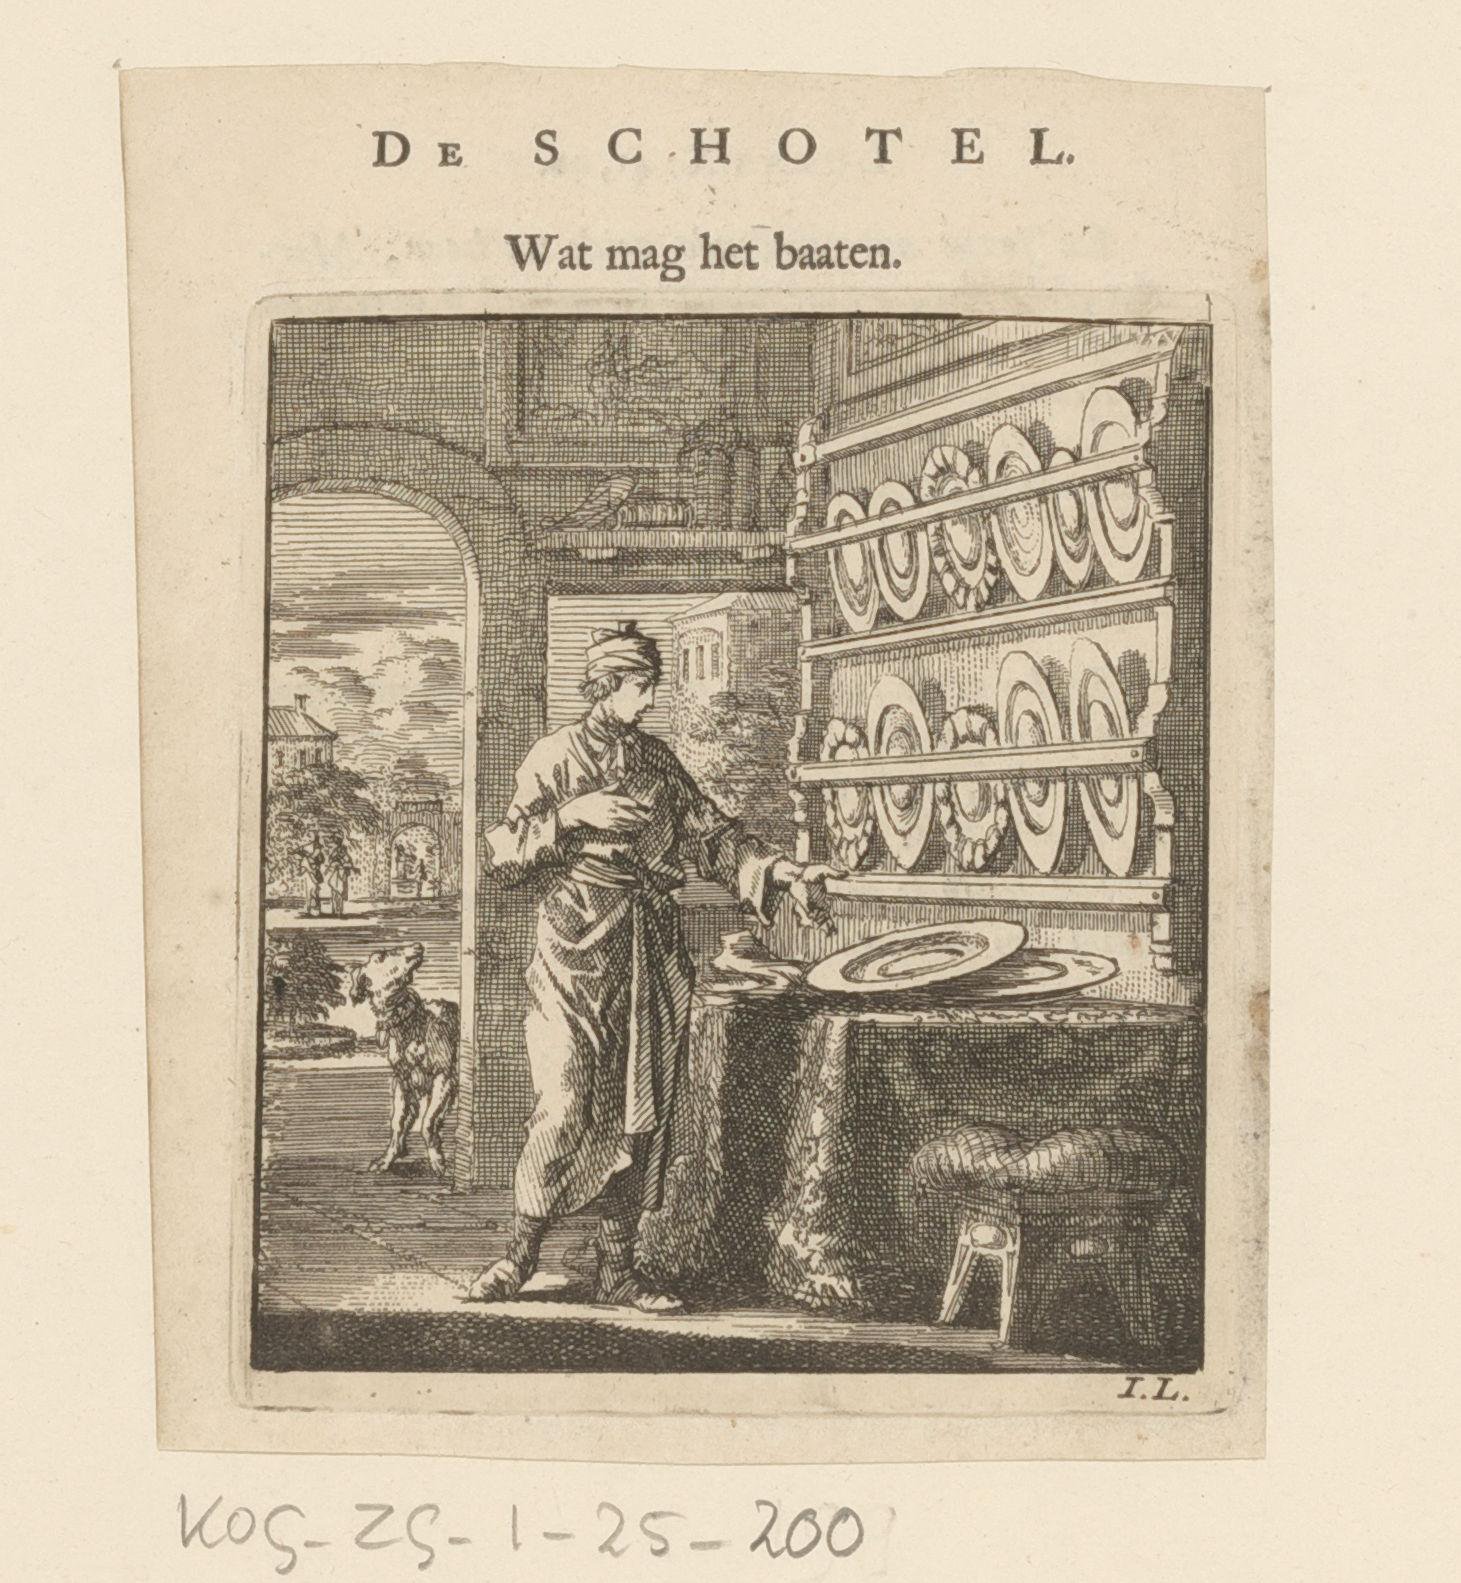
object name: print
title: De Schotel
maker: jan luyken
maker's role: draughtsman, print maker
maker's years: 1649-1712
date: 1711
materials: paper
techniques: etching, letterpress printing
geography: amsterdam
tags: dish, plate, saucer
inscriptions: collector's mark: Lugt 1641, stamp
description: Prent uit: Luyken, Jan. Het leerzaam huisraad, vertoond in vyftig konstige figuuren, met godlyke spreuken en stichtelyke verzen. Amsterdam: weduwe Pieter Arentsz. II en Cornelis van der Sys, 1711, p. 38.